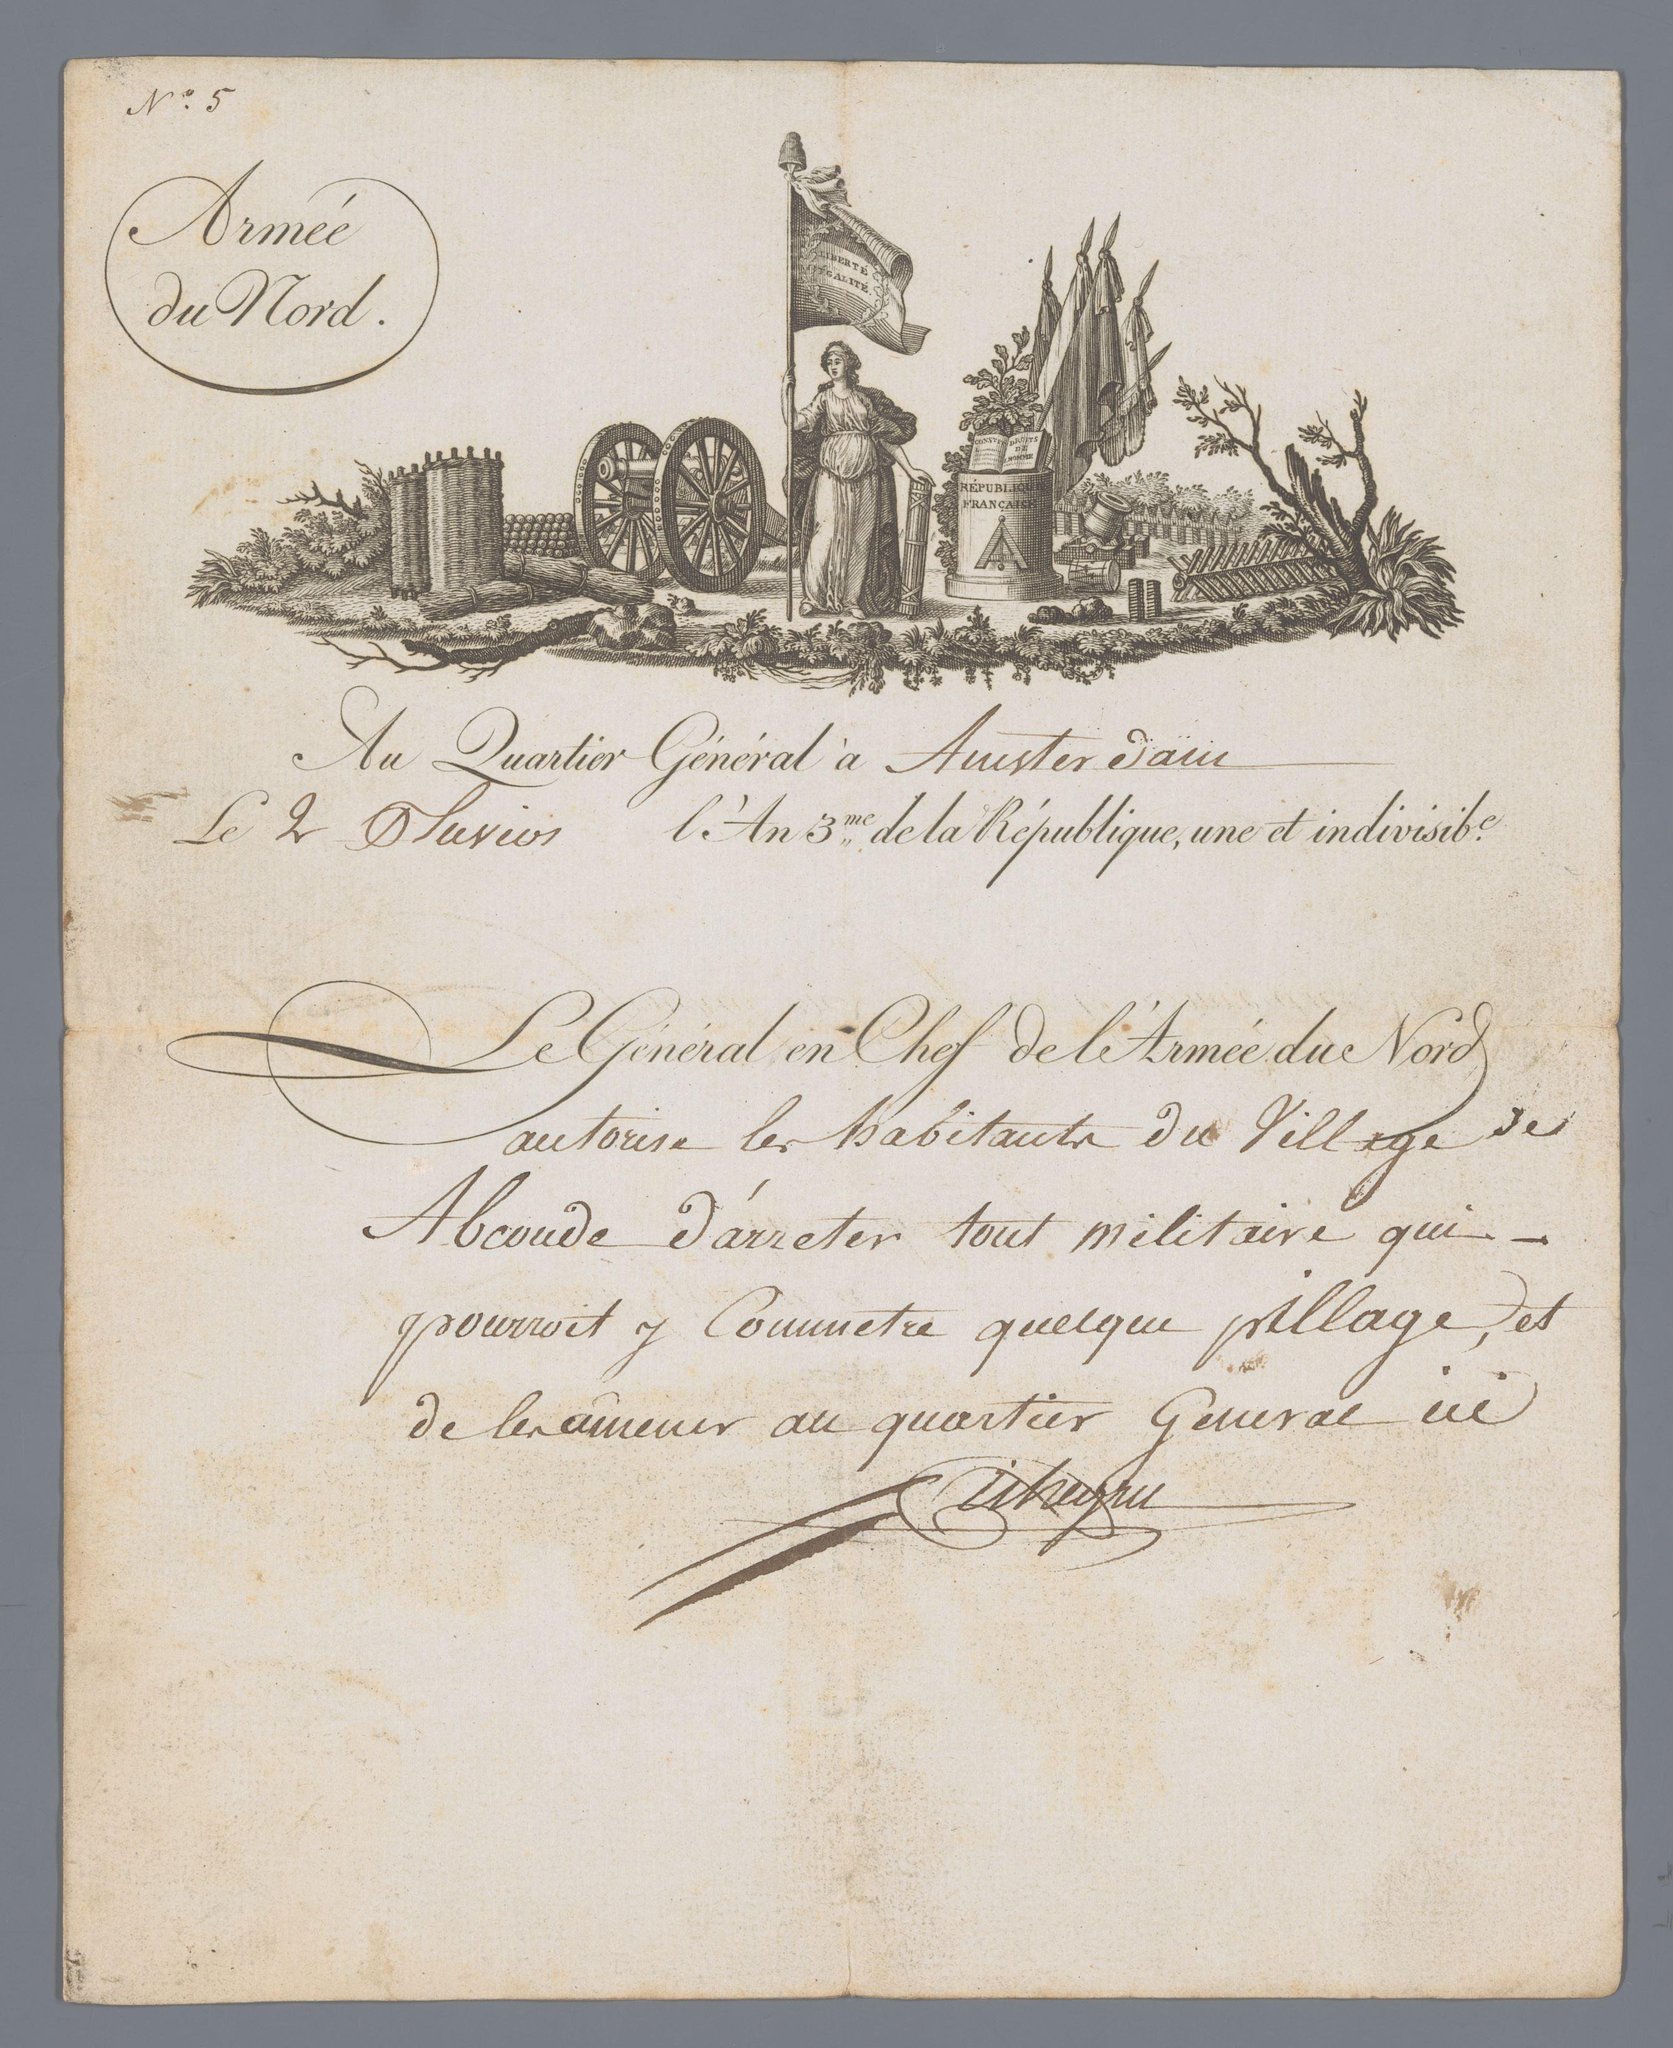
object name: document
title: Vrouw met vaandel temidden van wapentuig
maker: jean-charles pichegru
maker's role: politician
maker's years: 1761-1804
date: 1795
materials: ink, paper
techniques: printing, writing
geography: amsterdam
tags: paris, politician, jean-charles pichegru, netherlands